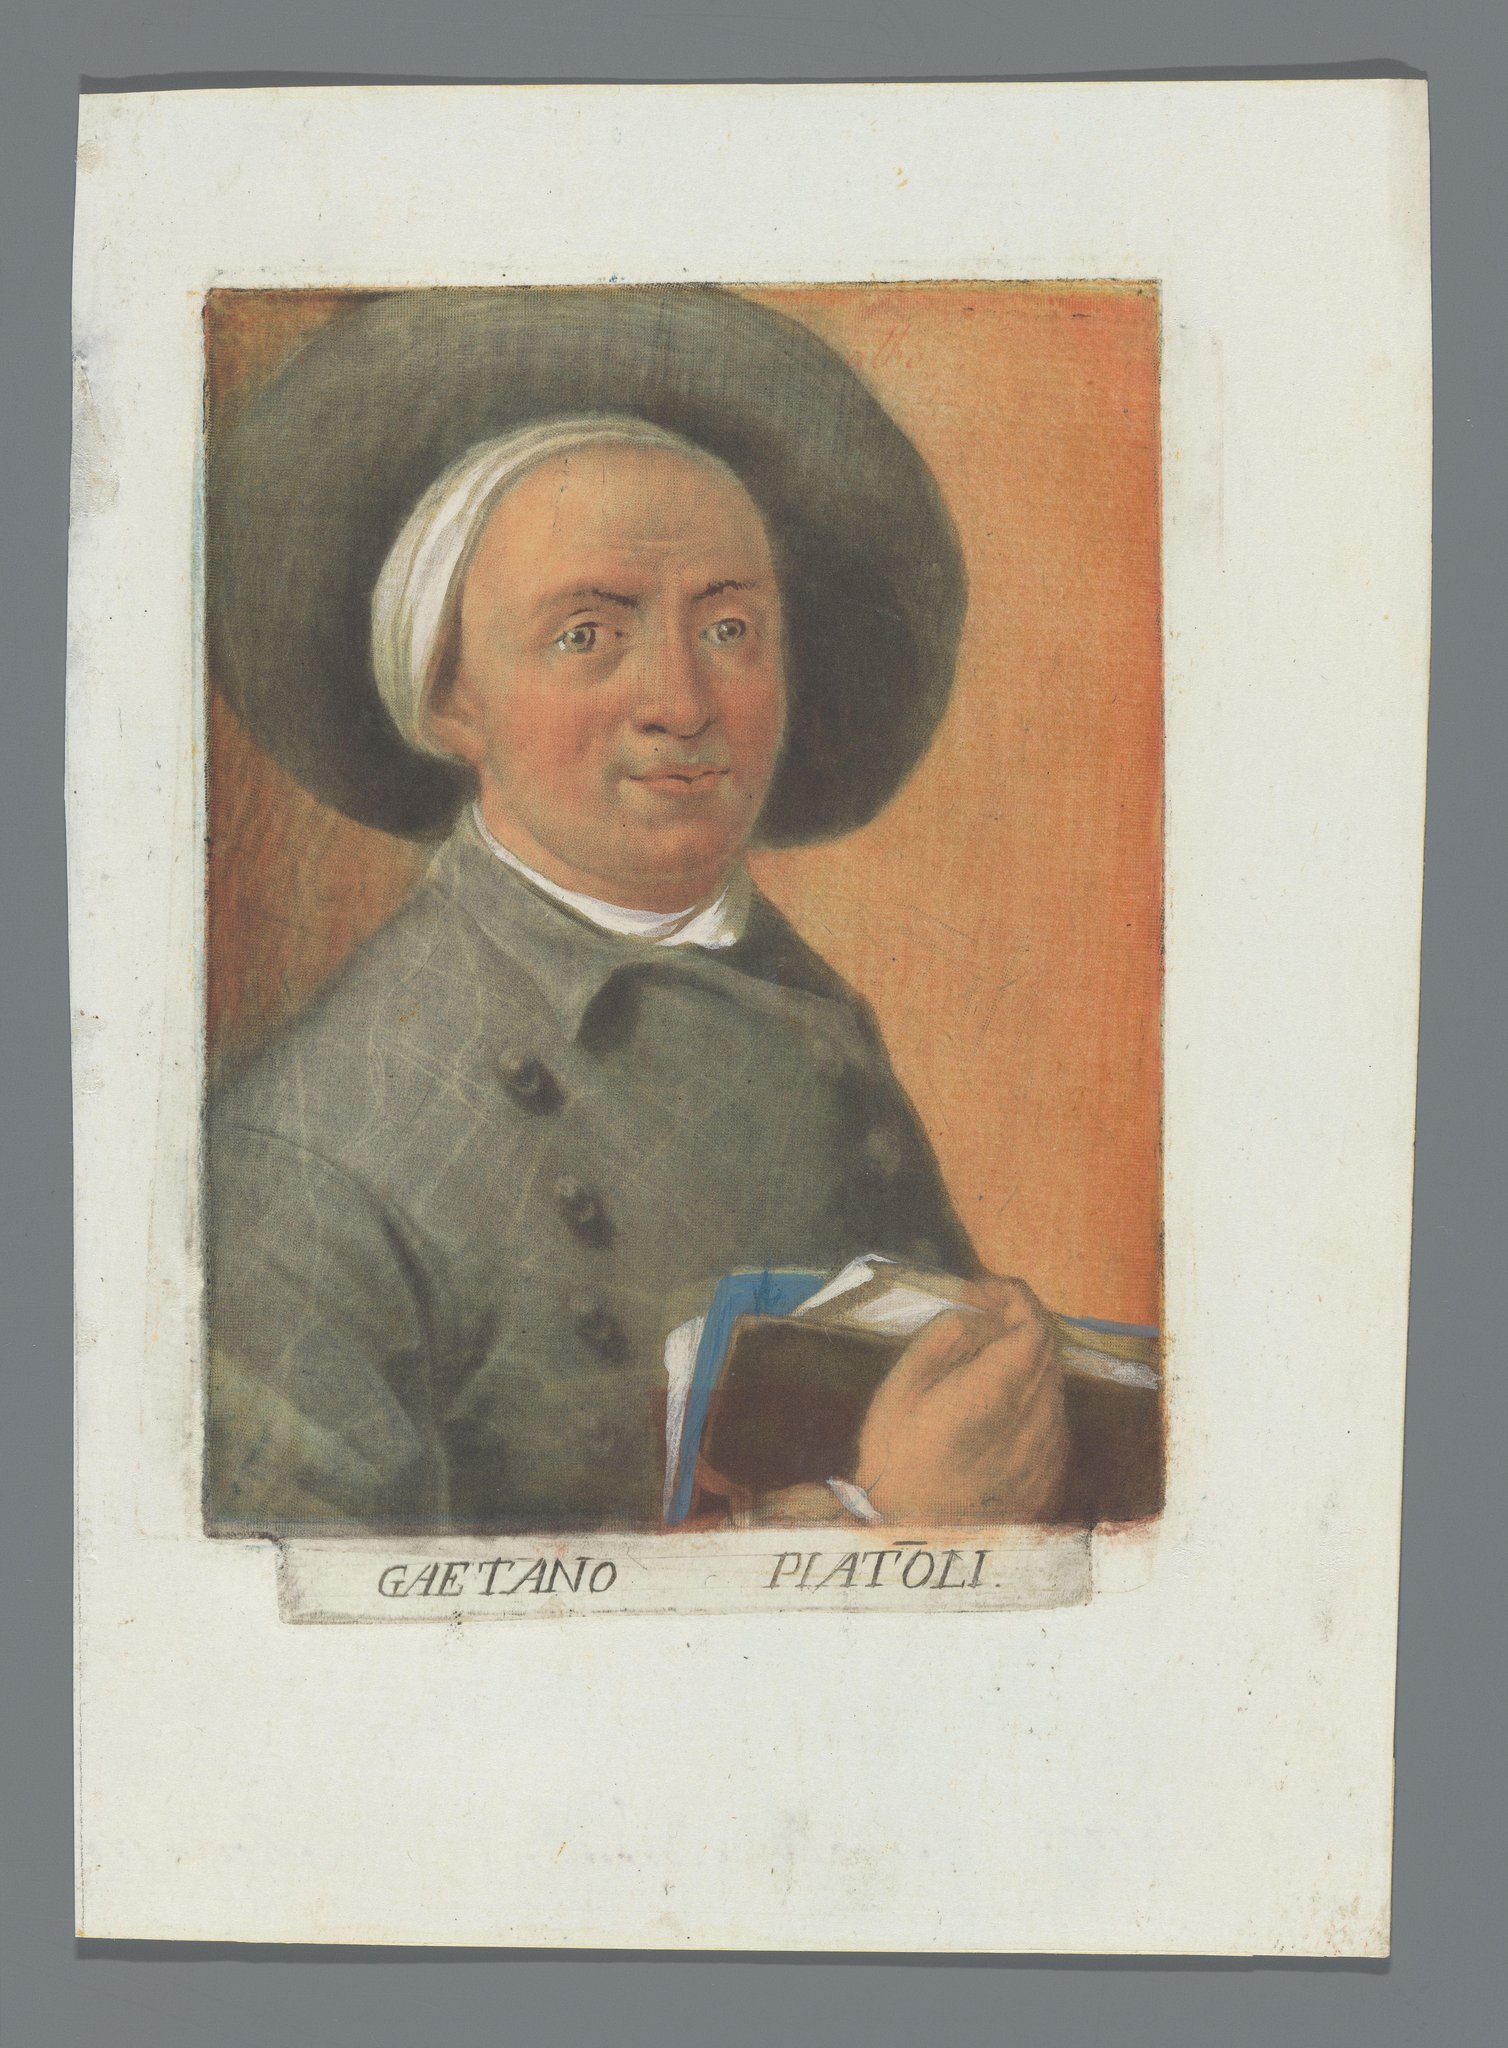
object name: print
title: Gaetano Piatoli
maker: carlo lasinio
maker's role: painter, print maker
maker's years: 1759-1838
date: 1789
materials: gouache, paper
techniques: color mezzotint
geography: florence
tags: gaetano piattoli i (il vecchio), historical persons, portrait, self-portrait of painter, portrait, self-portrait of artist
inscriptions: number: ‘89’, collector's mark: Lugt 2228, inscription:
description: Een prent uit een groep van veertig kleurendrukken met kunstenaarsportretten, gebaseerd op de collectie geschilderde zelfportretten van kunstenaars verzameld door de Medici in Florence. De groep maakt deel uit van het grote werk van Lasinio ‘Gli Autoritratti della Real Galleria di Firenze’, uitgegeven in 1789 met omstreeks 350 kunstenaarsportretten. Van deze uitgave is tot nog toe is geen compleet exemplaar bekend. In de inspringende marges onderaan de prenten zijn de namen van de kunstenaars aangebracht en soms hun levensdata en de plaats van geboorte en sterven en een enkele maal de signatuur van Lasinio en dat van de drukker Labrelis. Getuige de bindgaatjes en lijmresten moeten de prenten ingebonden zijn geweest in een album. De meeste prenten zijn verso voorzien van nummers in potlood, met als laagste nummer 2 en hoogste 93. Tevens zijn er verso Italiaanse opschriften in pen aangebracht met de levensdata van de kunstenaars en de school waartoe zij worden gerekend. Deze opschriften zijn vrijwel alle deels afgesneden. Elf prenten zijn niet genummerd en niet voorzien van opschriften. Deze laatste elf zijn alle gedrukt op blauw papier.